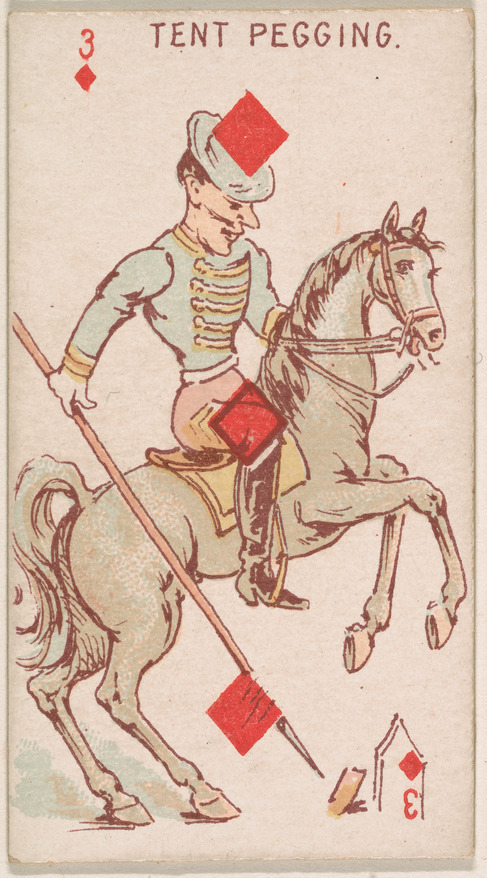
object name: print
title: Three of Diamonds, Tent Pegging, from Harlequin Cards, 2nd Series (N220) issued by Kinney Bros.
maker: kinney brothers tobacco company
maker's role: publisher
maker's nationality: american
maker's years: 1869-2011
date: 1889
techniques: color lithograph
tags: men,playing cards,horses